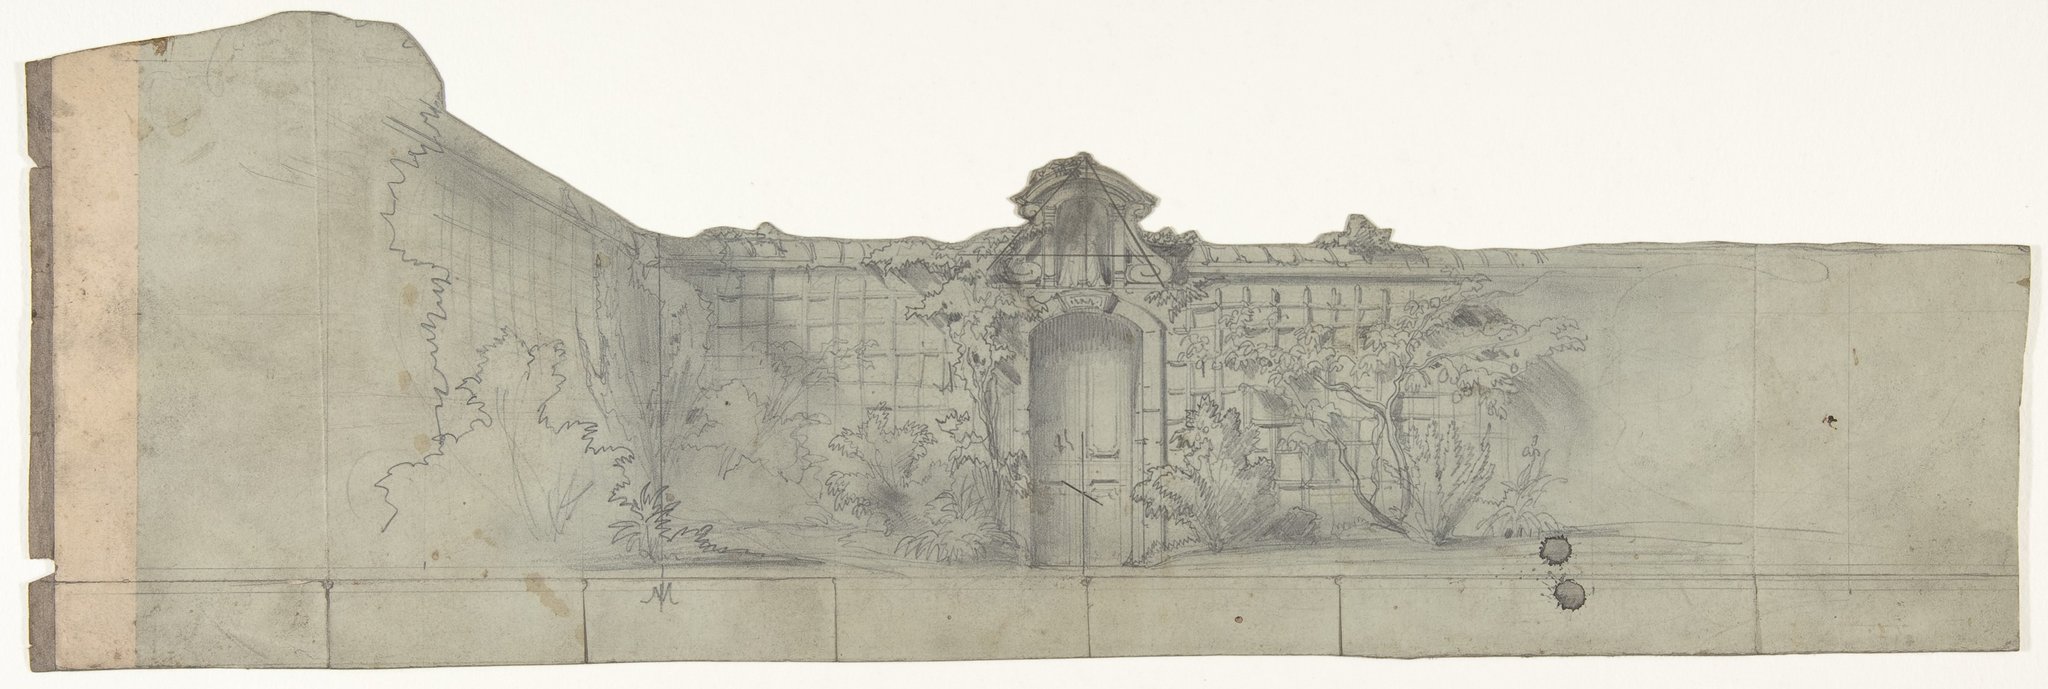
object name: drawing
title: Design for a Stage Set at the Opéra, Paris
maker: eugène cicéri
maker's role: artist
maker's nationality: french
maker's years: 1813-1890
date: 1830-1890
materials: graphite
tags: stage design